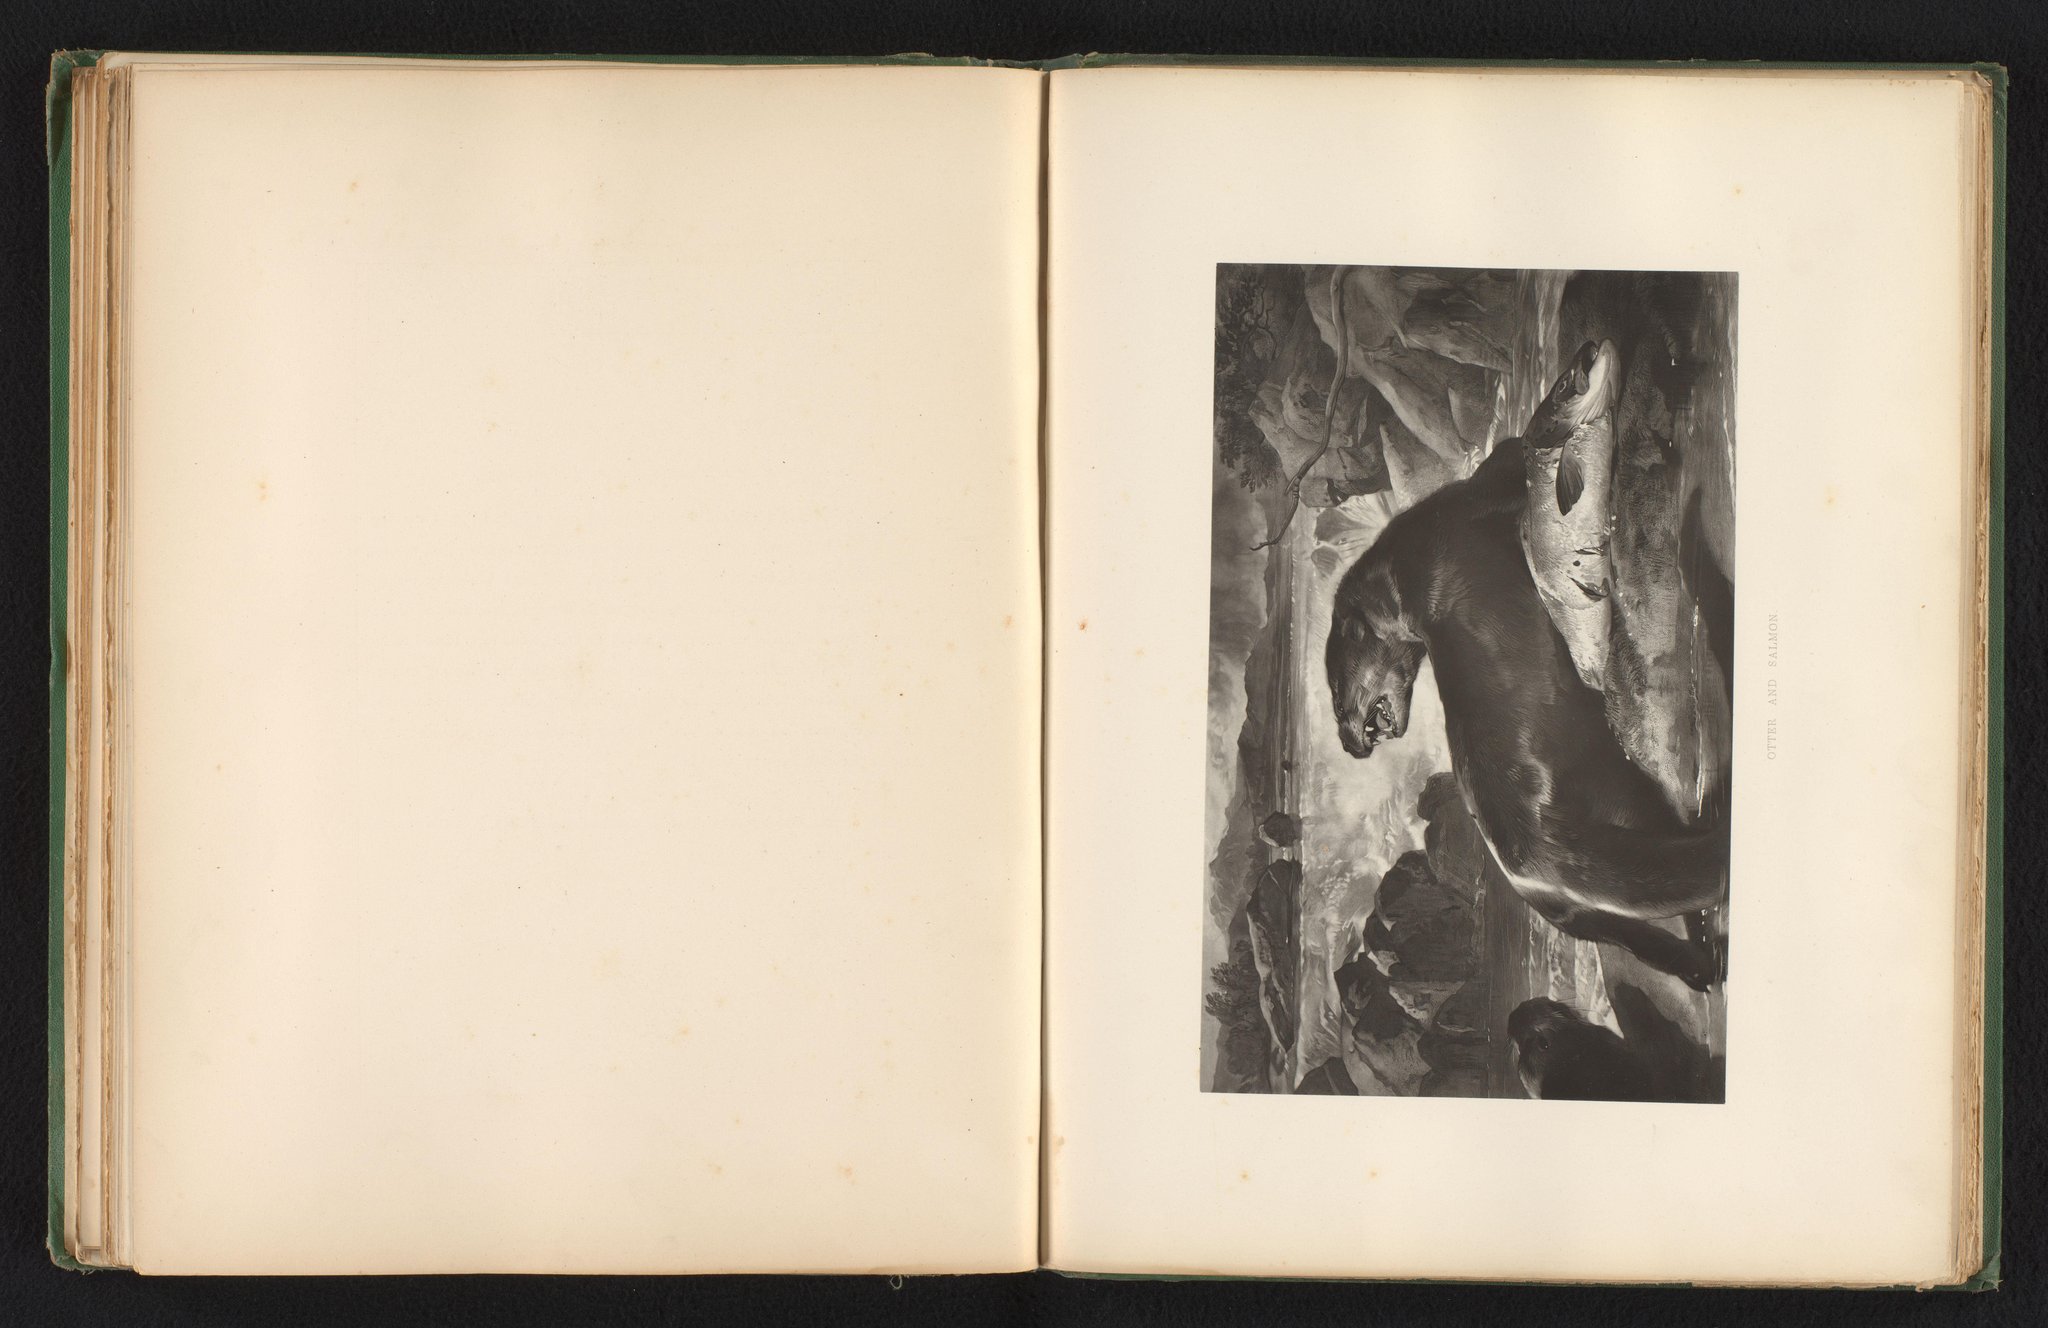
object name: photomechanical print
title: Otter and salmon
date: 1878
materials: paper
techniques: woodburytype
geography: london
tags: bony fishes: salmon, beasts of prey, predatory animals: otter